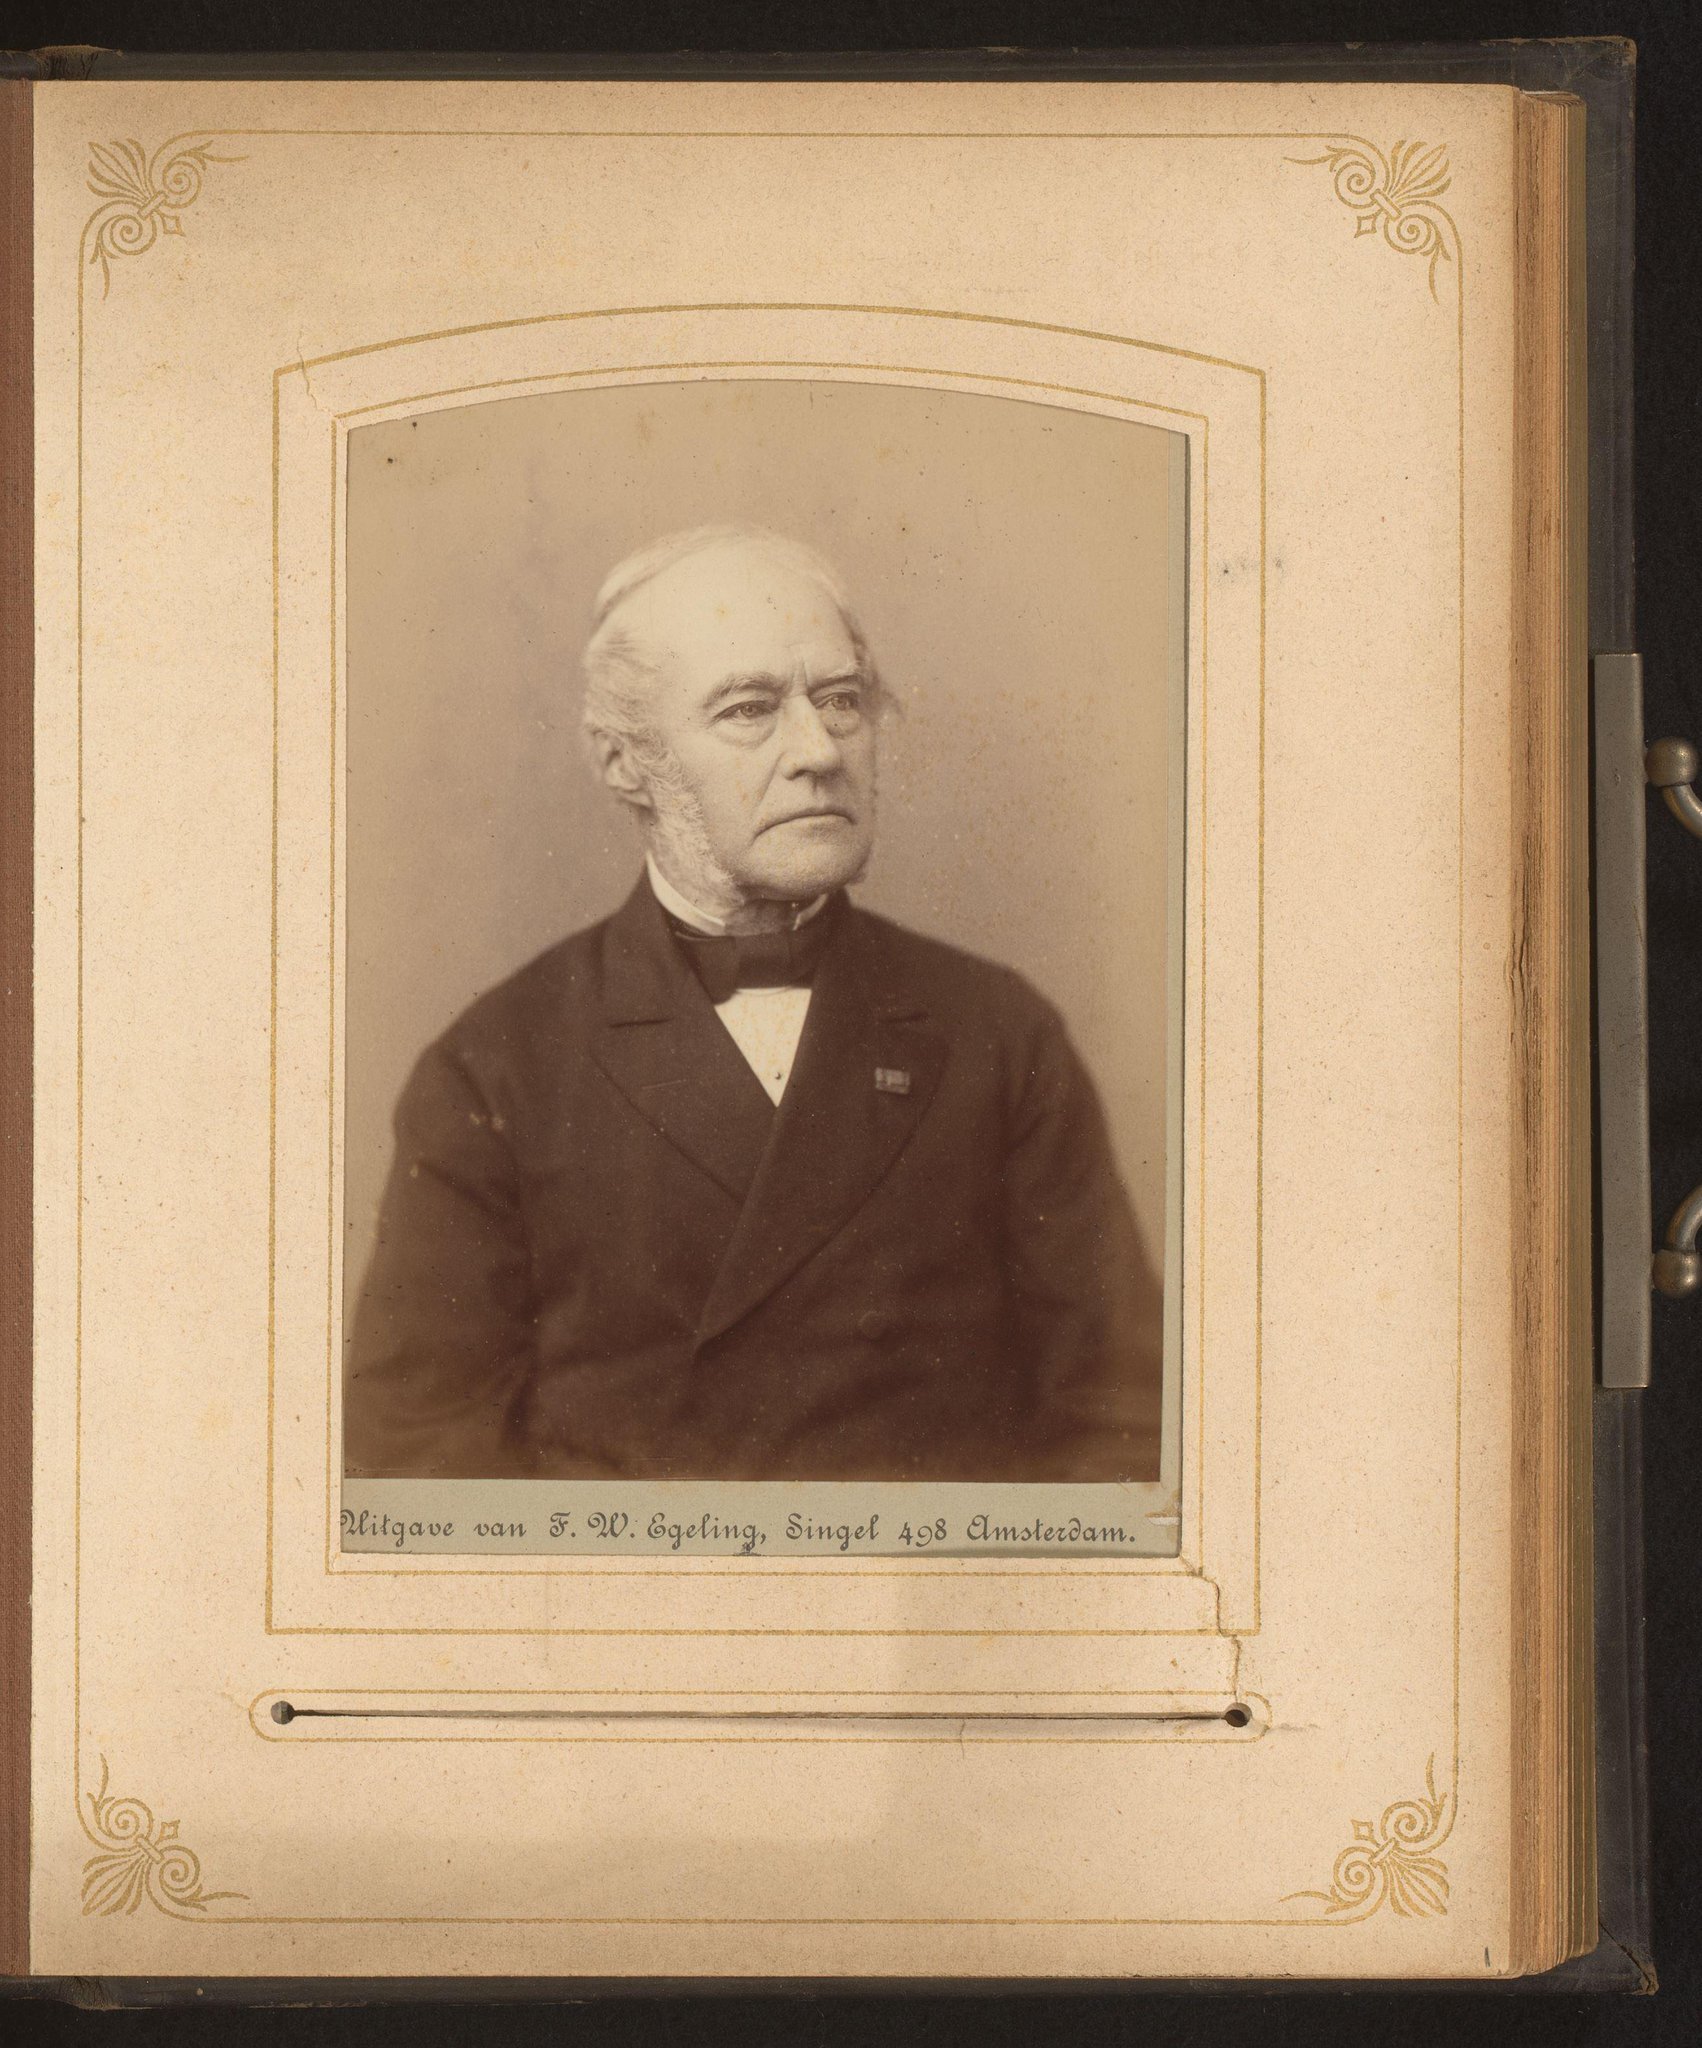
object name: album leaf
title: Portret van een man met vlinderstrik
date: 1860-1900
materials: cardboard, photographic support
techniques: albumen print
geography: amsterdam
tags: historical persons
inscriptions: inscription: ‘Uitgave van F. W. Egeling, Singel 498 Amsterdam.’